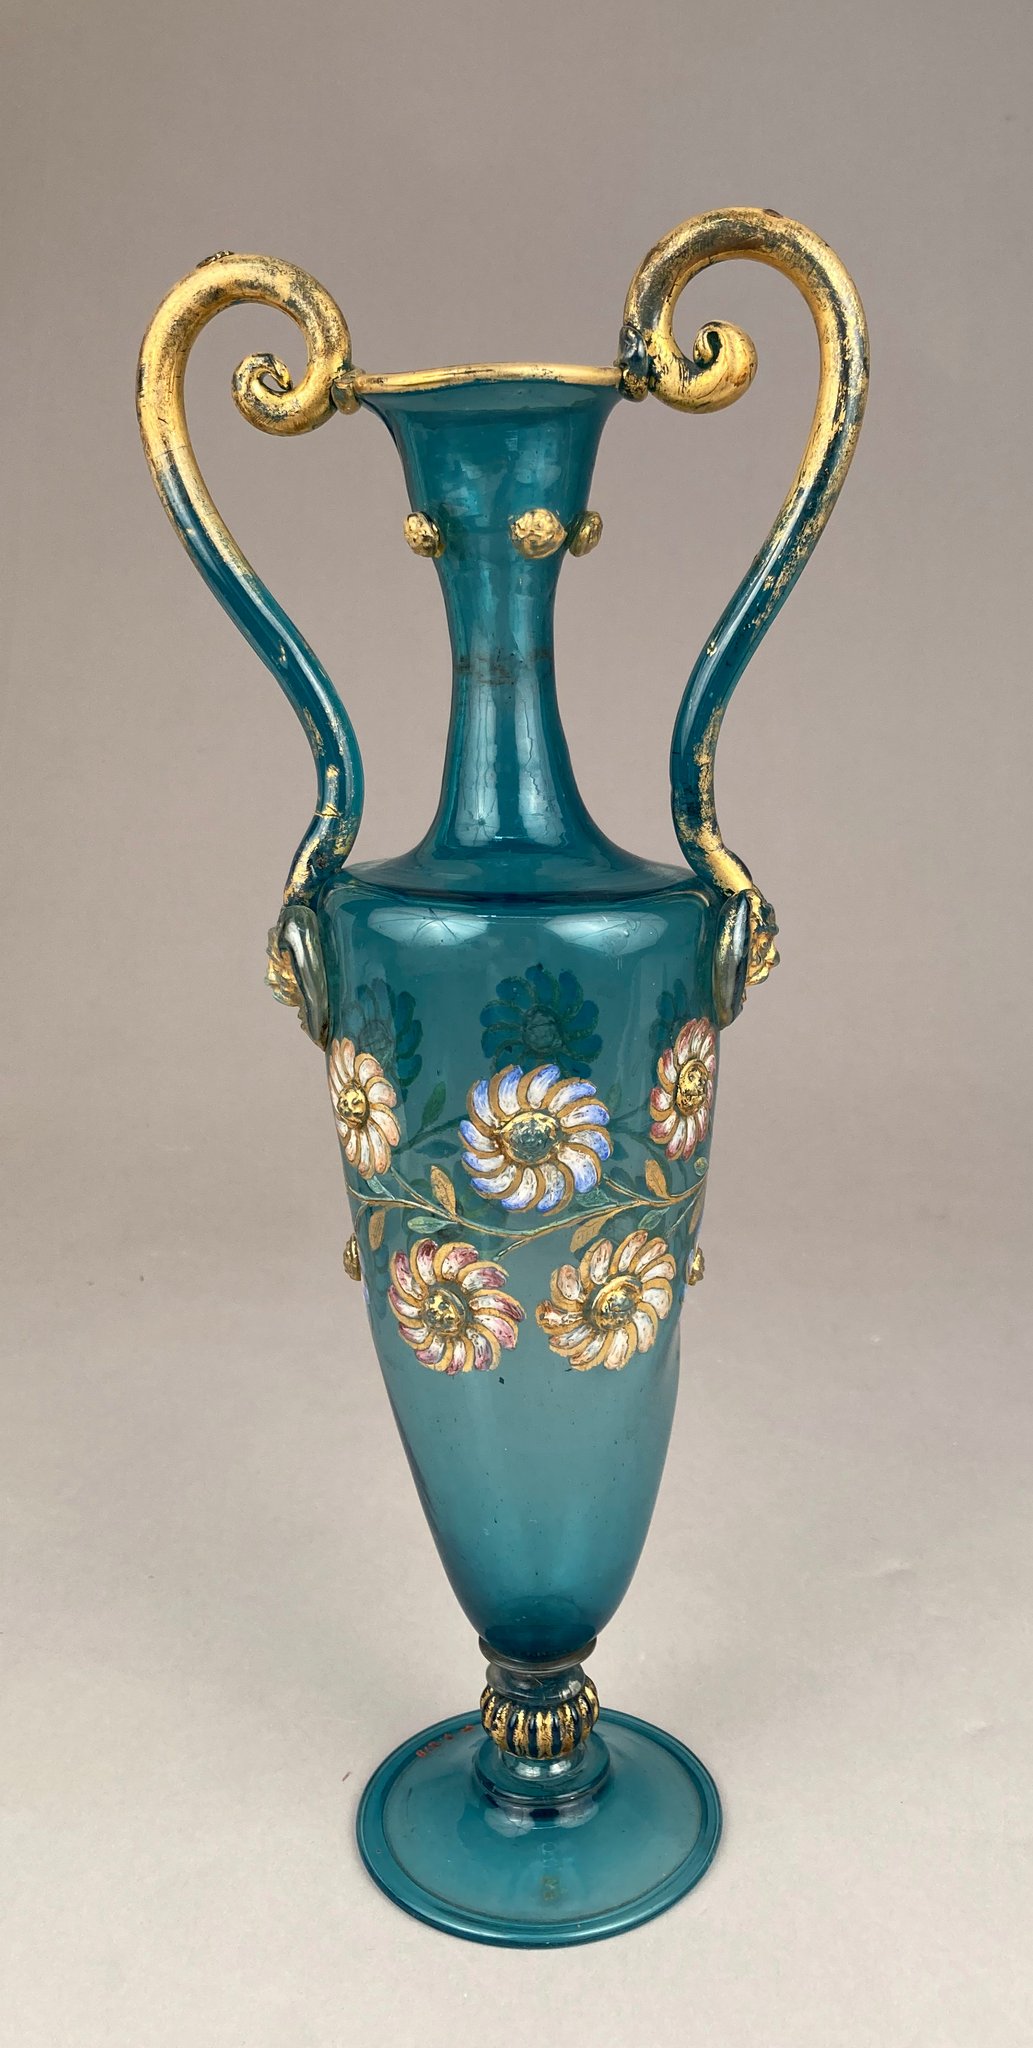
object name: vase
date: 1801-1900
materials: glass